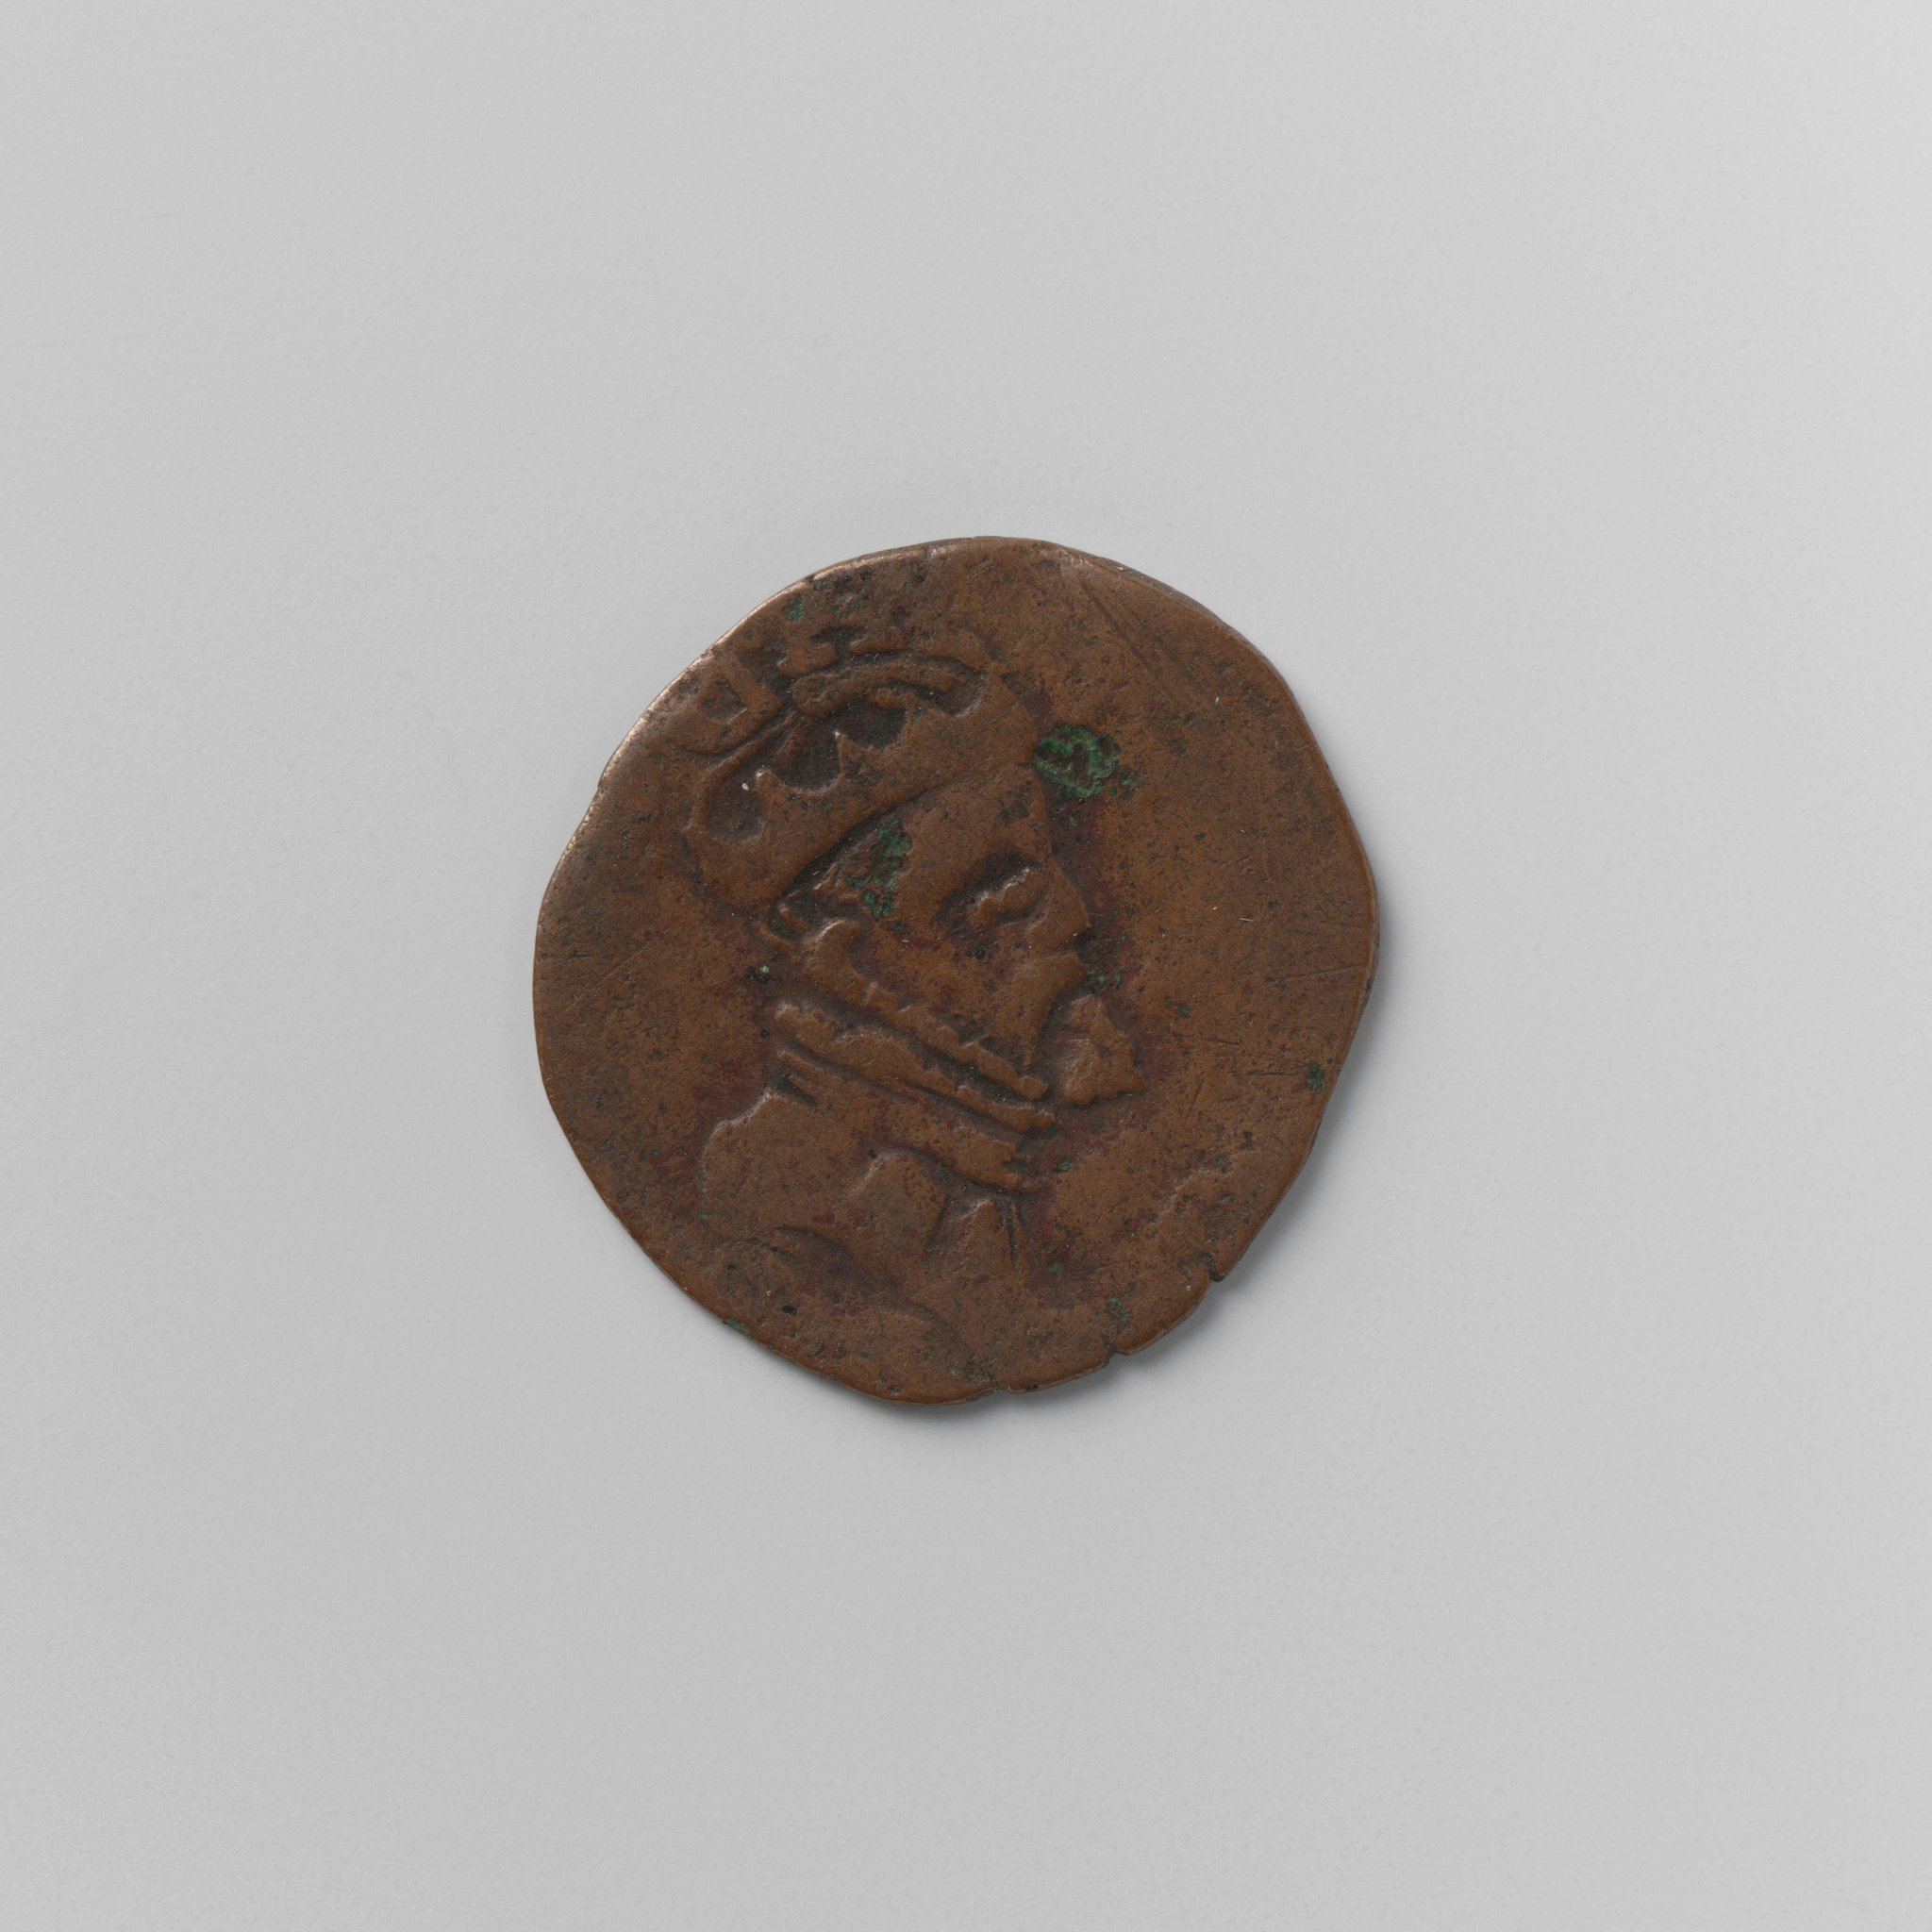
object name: coin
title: Brabant, Philips II, korte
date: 1555-1598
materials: copper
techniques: striking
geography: antwerp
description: Koperen munt. Voorzijde: gekroond hoofd van Philips II naar rechts. Keerzijde: in een randversiering stokkenkruis Tussen benen vuurijzers. Geen omschrift.